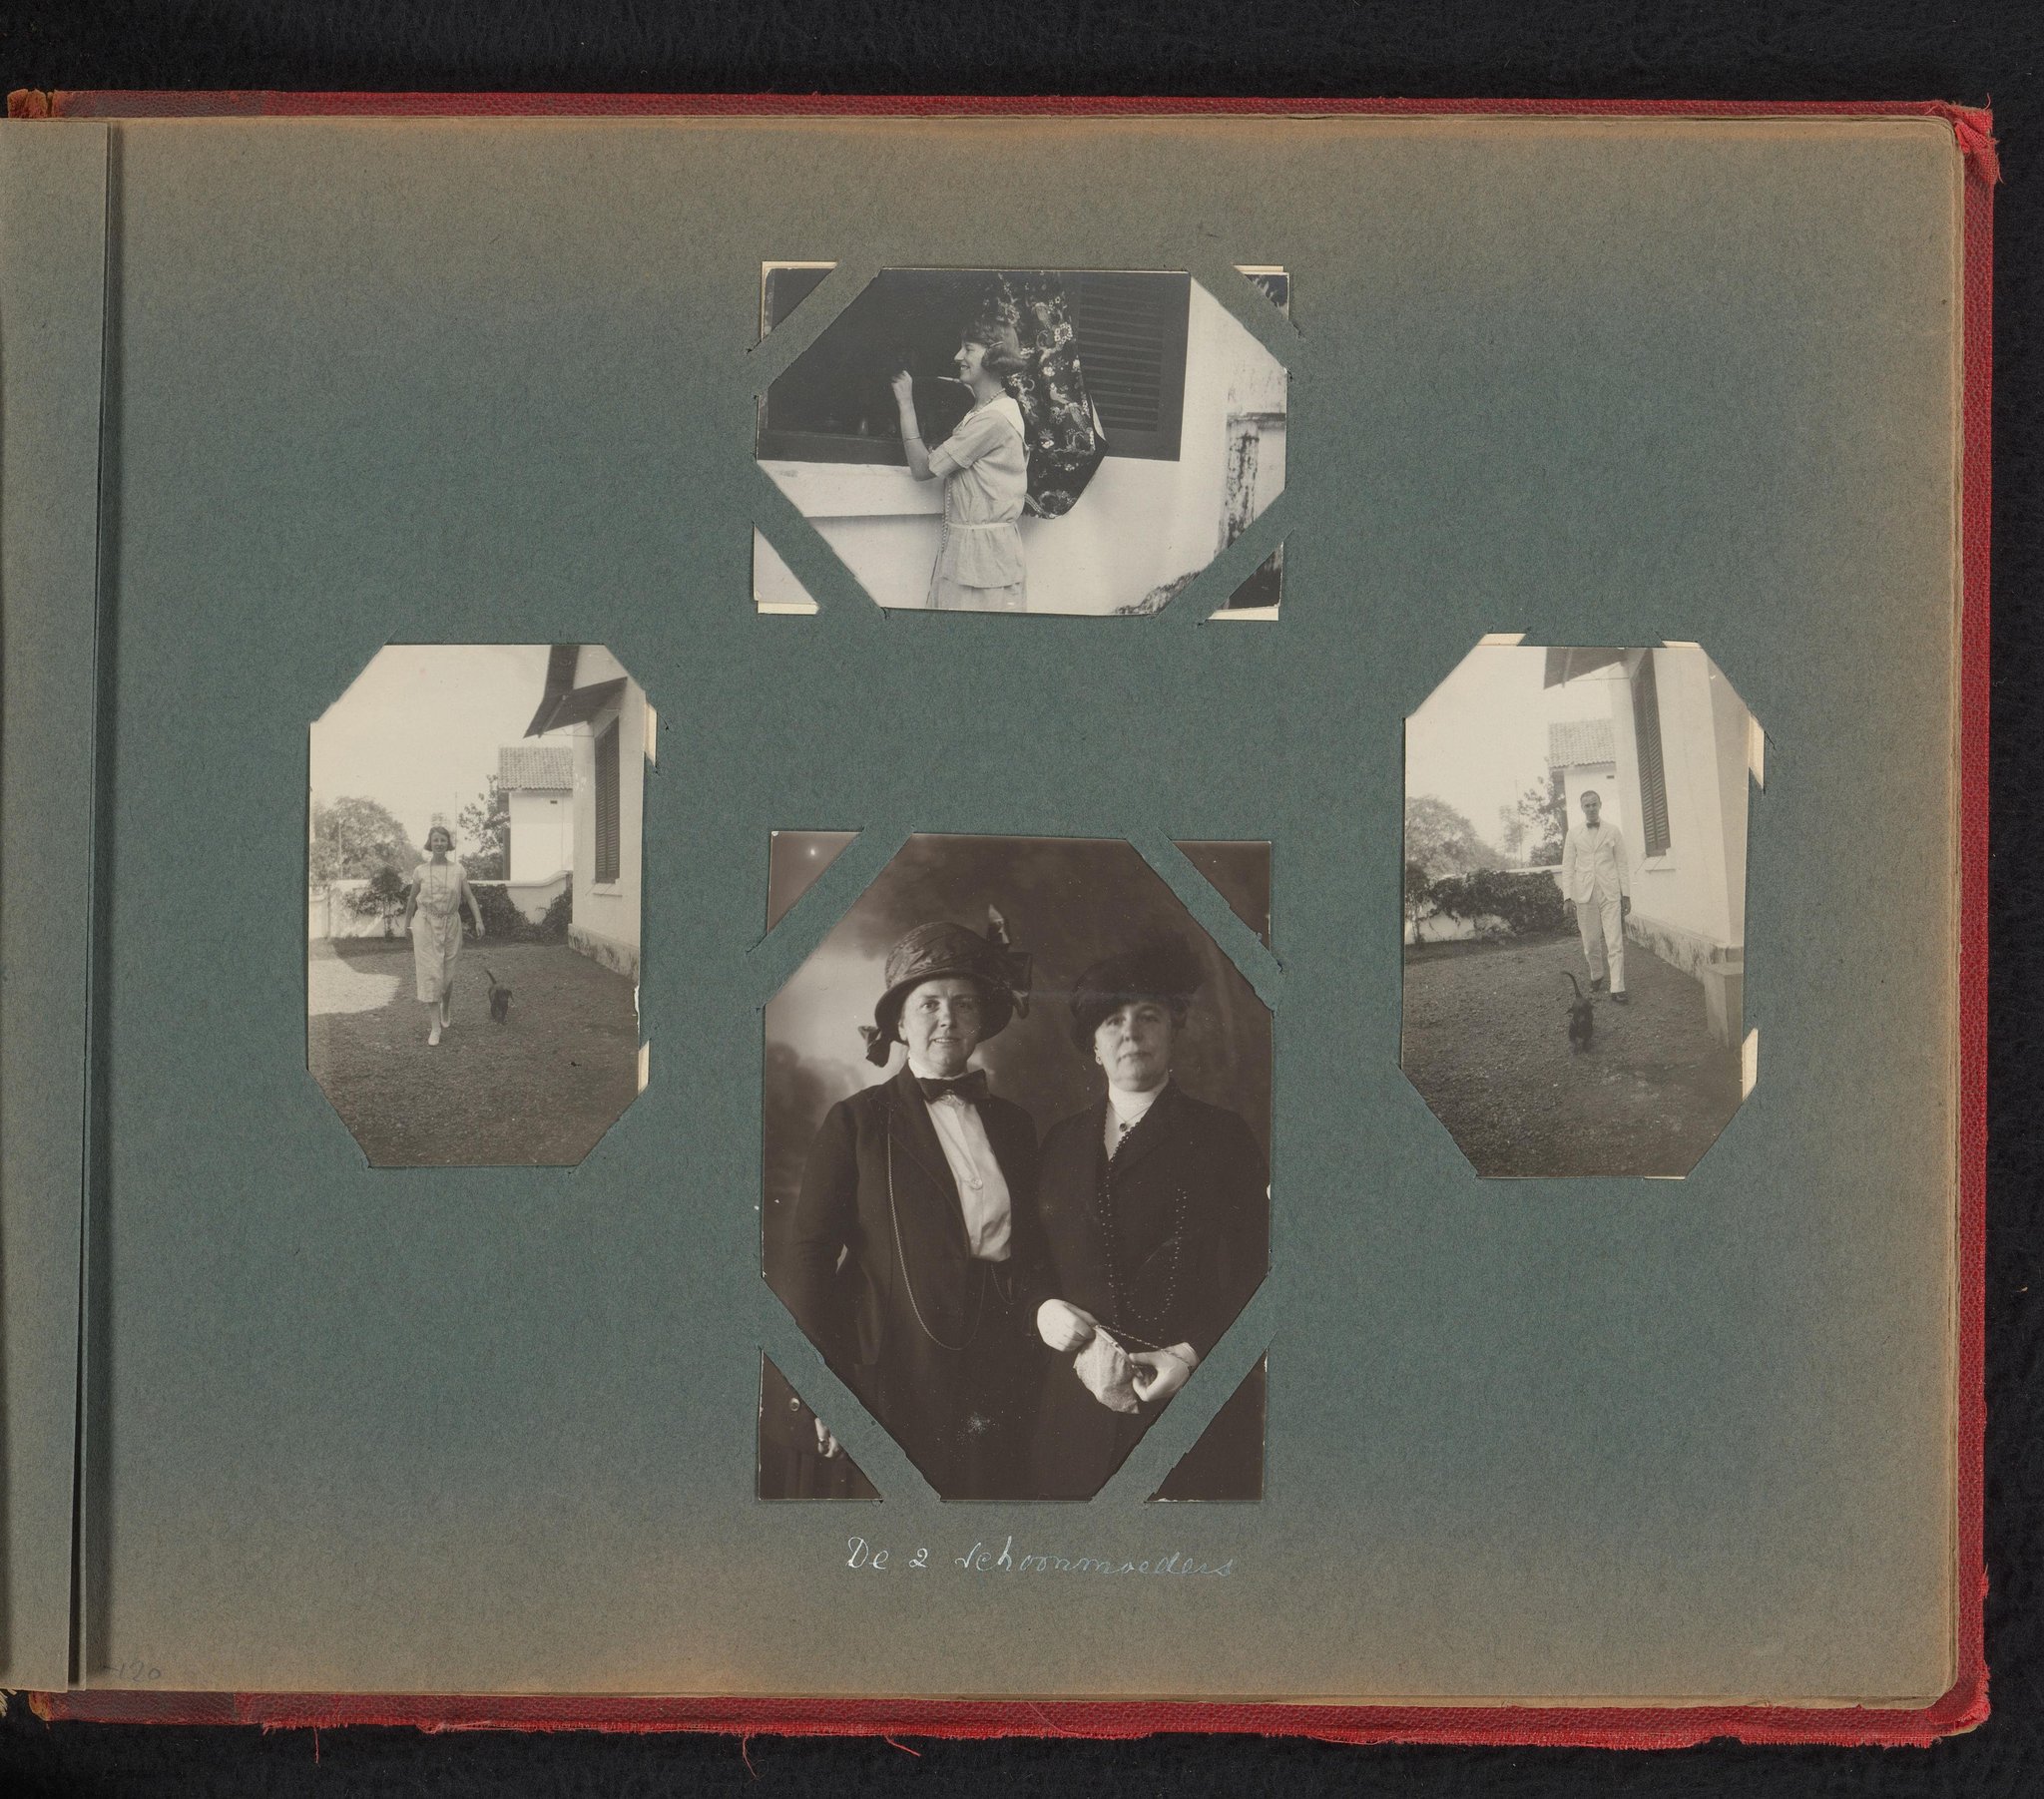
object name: album leaf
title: Wijk aan Zee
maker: charlotte alida boelen-matthes (lot)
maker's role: amateurfotograaf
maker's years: 1889-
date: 1922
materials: paper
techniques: gelatin silver print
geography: wijk aan zee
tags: beach (as place of recreation)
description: Deze foto's zijn onderdeel van een album.